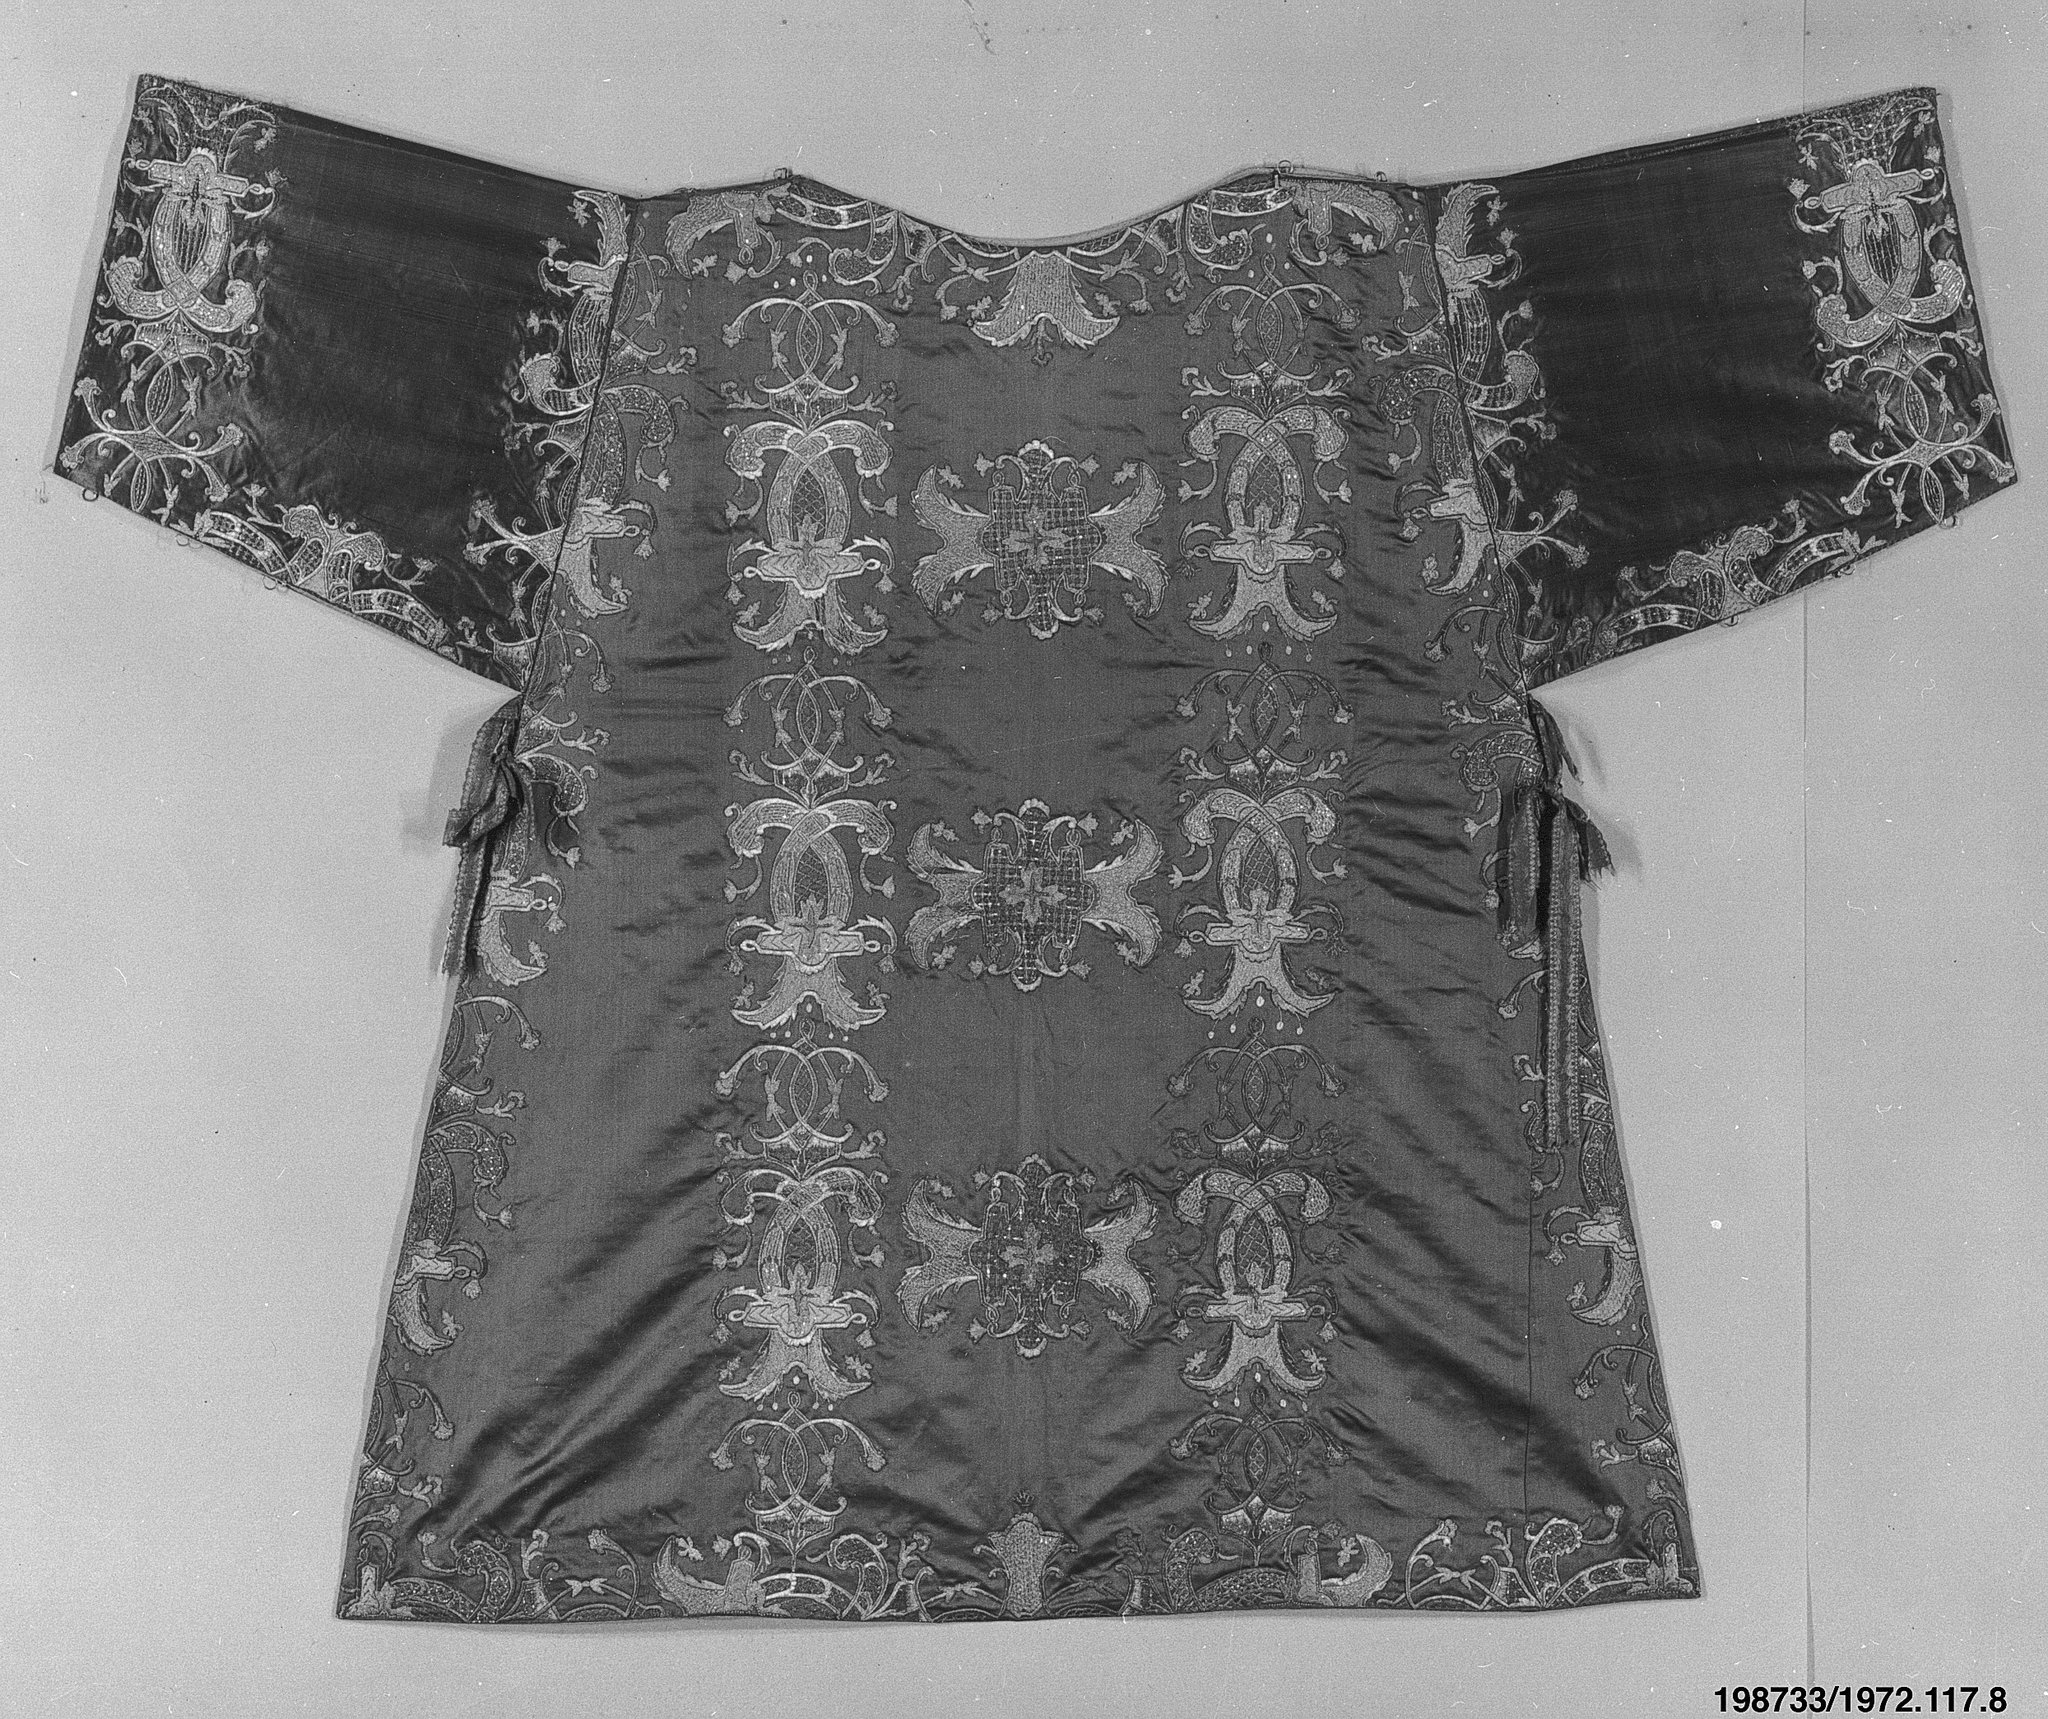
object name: dalmatic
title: Dalmatic (one of a pair)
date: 1830-1839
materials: cotton, metal thread, silk